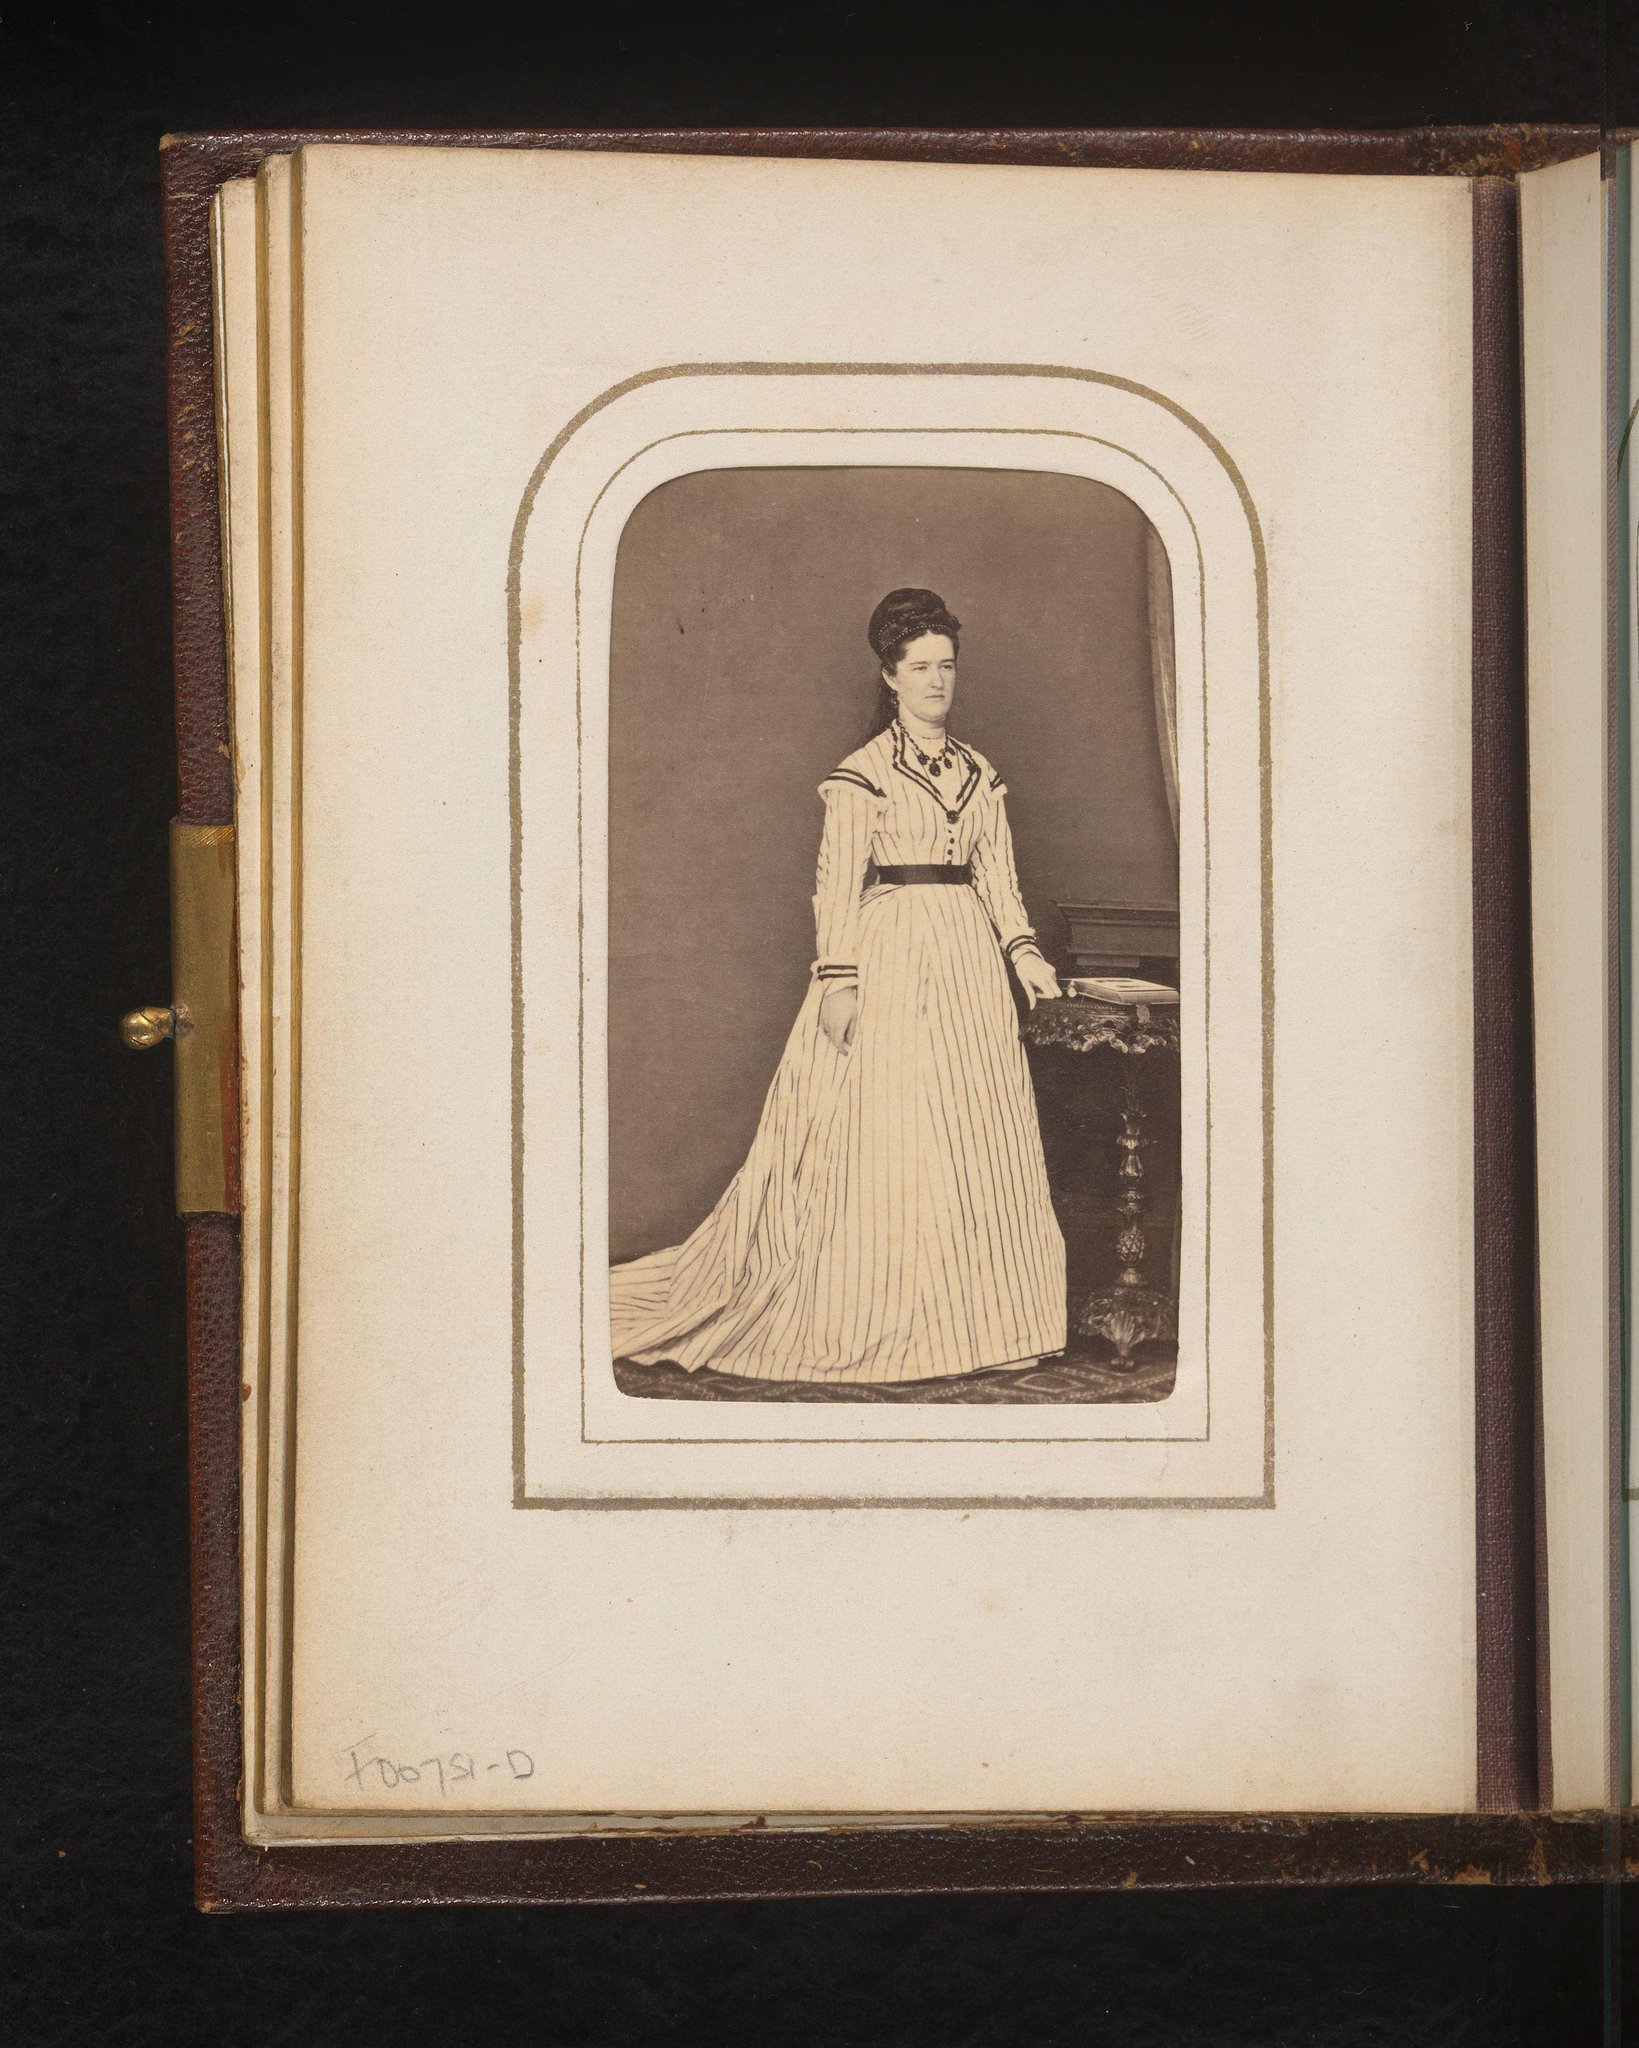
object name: carte de visite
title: Portret van een staande vrouw met ketting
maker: tandy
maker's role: fotograaf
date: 1870-1900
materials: cardboard, photographic support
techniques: albumen print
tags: standing figure, adult woman, necklace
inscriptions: inscription: ‘Tandy & Co/ Photographers/ Fort./ Bombay’, annotation: ‘[...] 6’